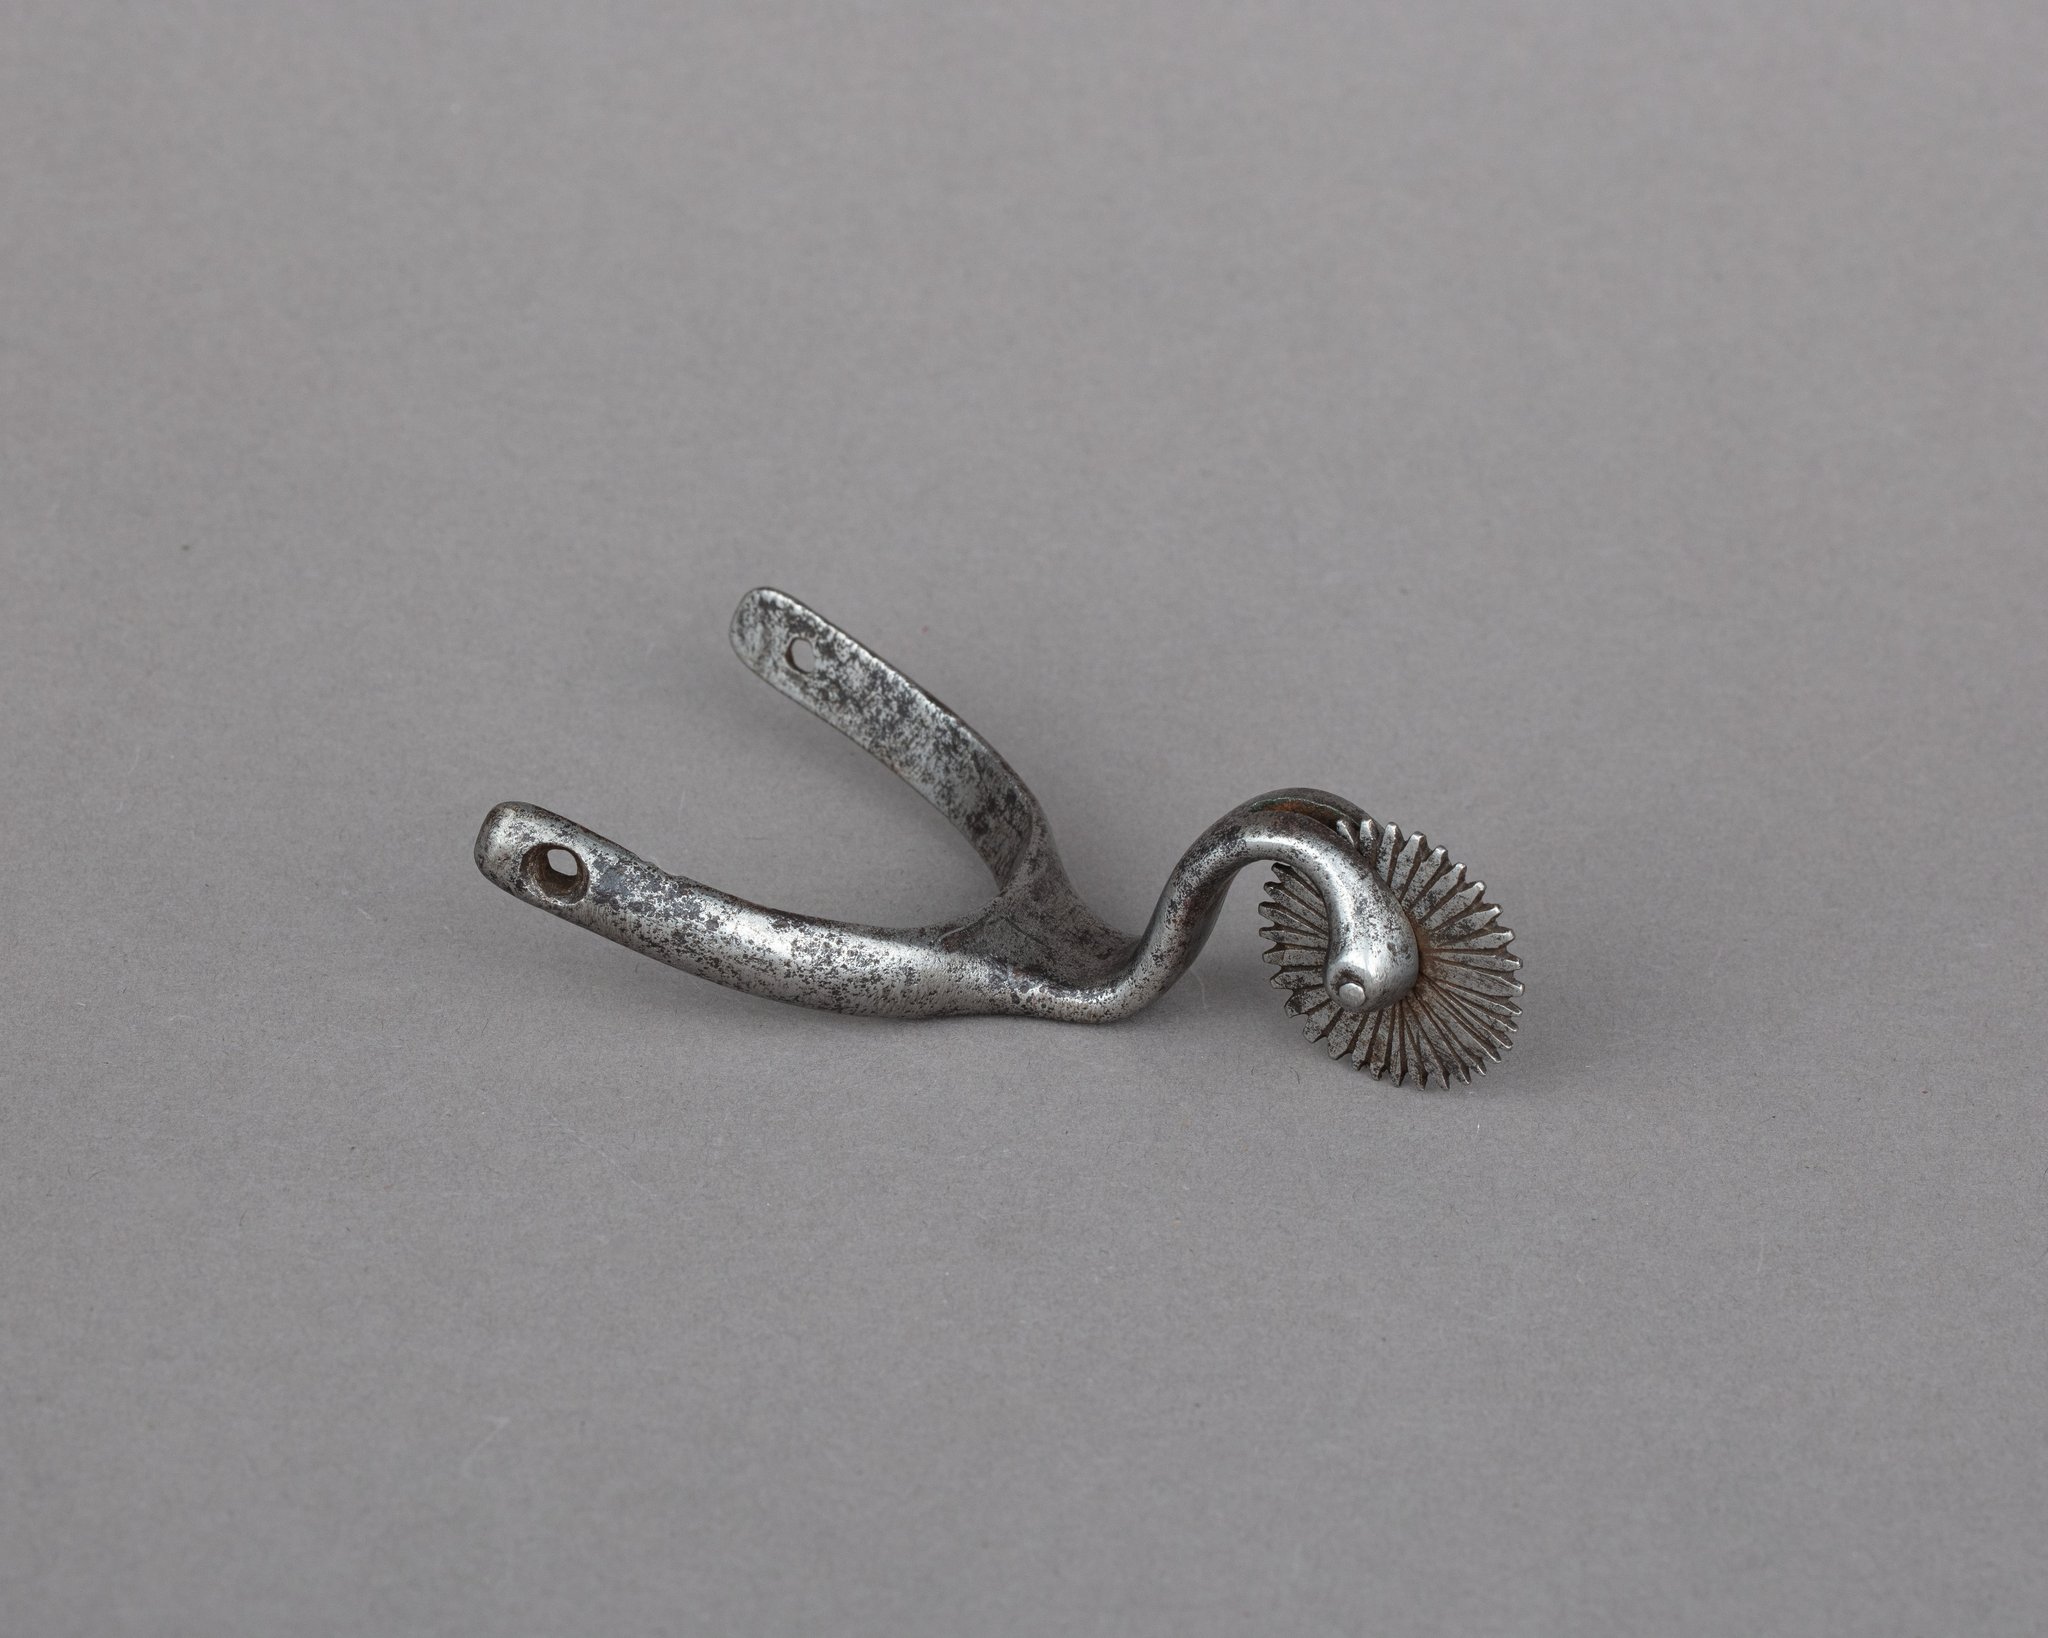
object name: spur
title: Rowel Spur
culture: european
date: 1801-1833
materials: metal alloy